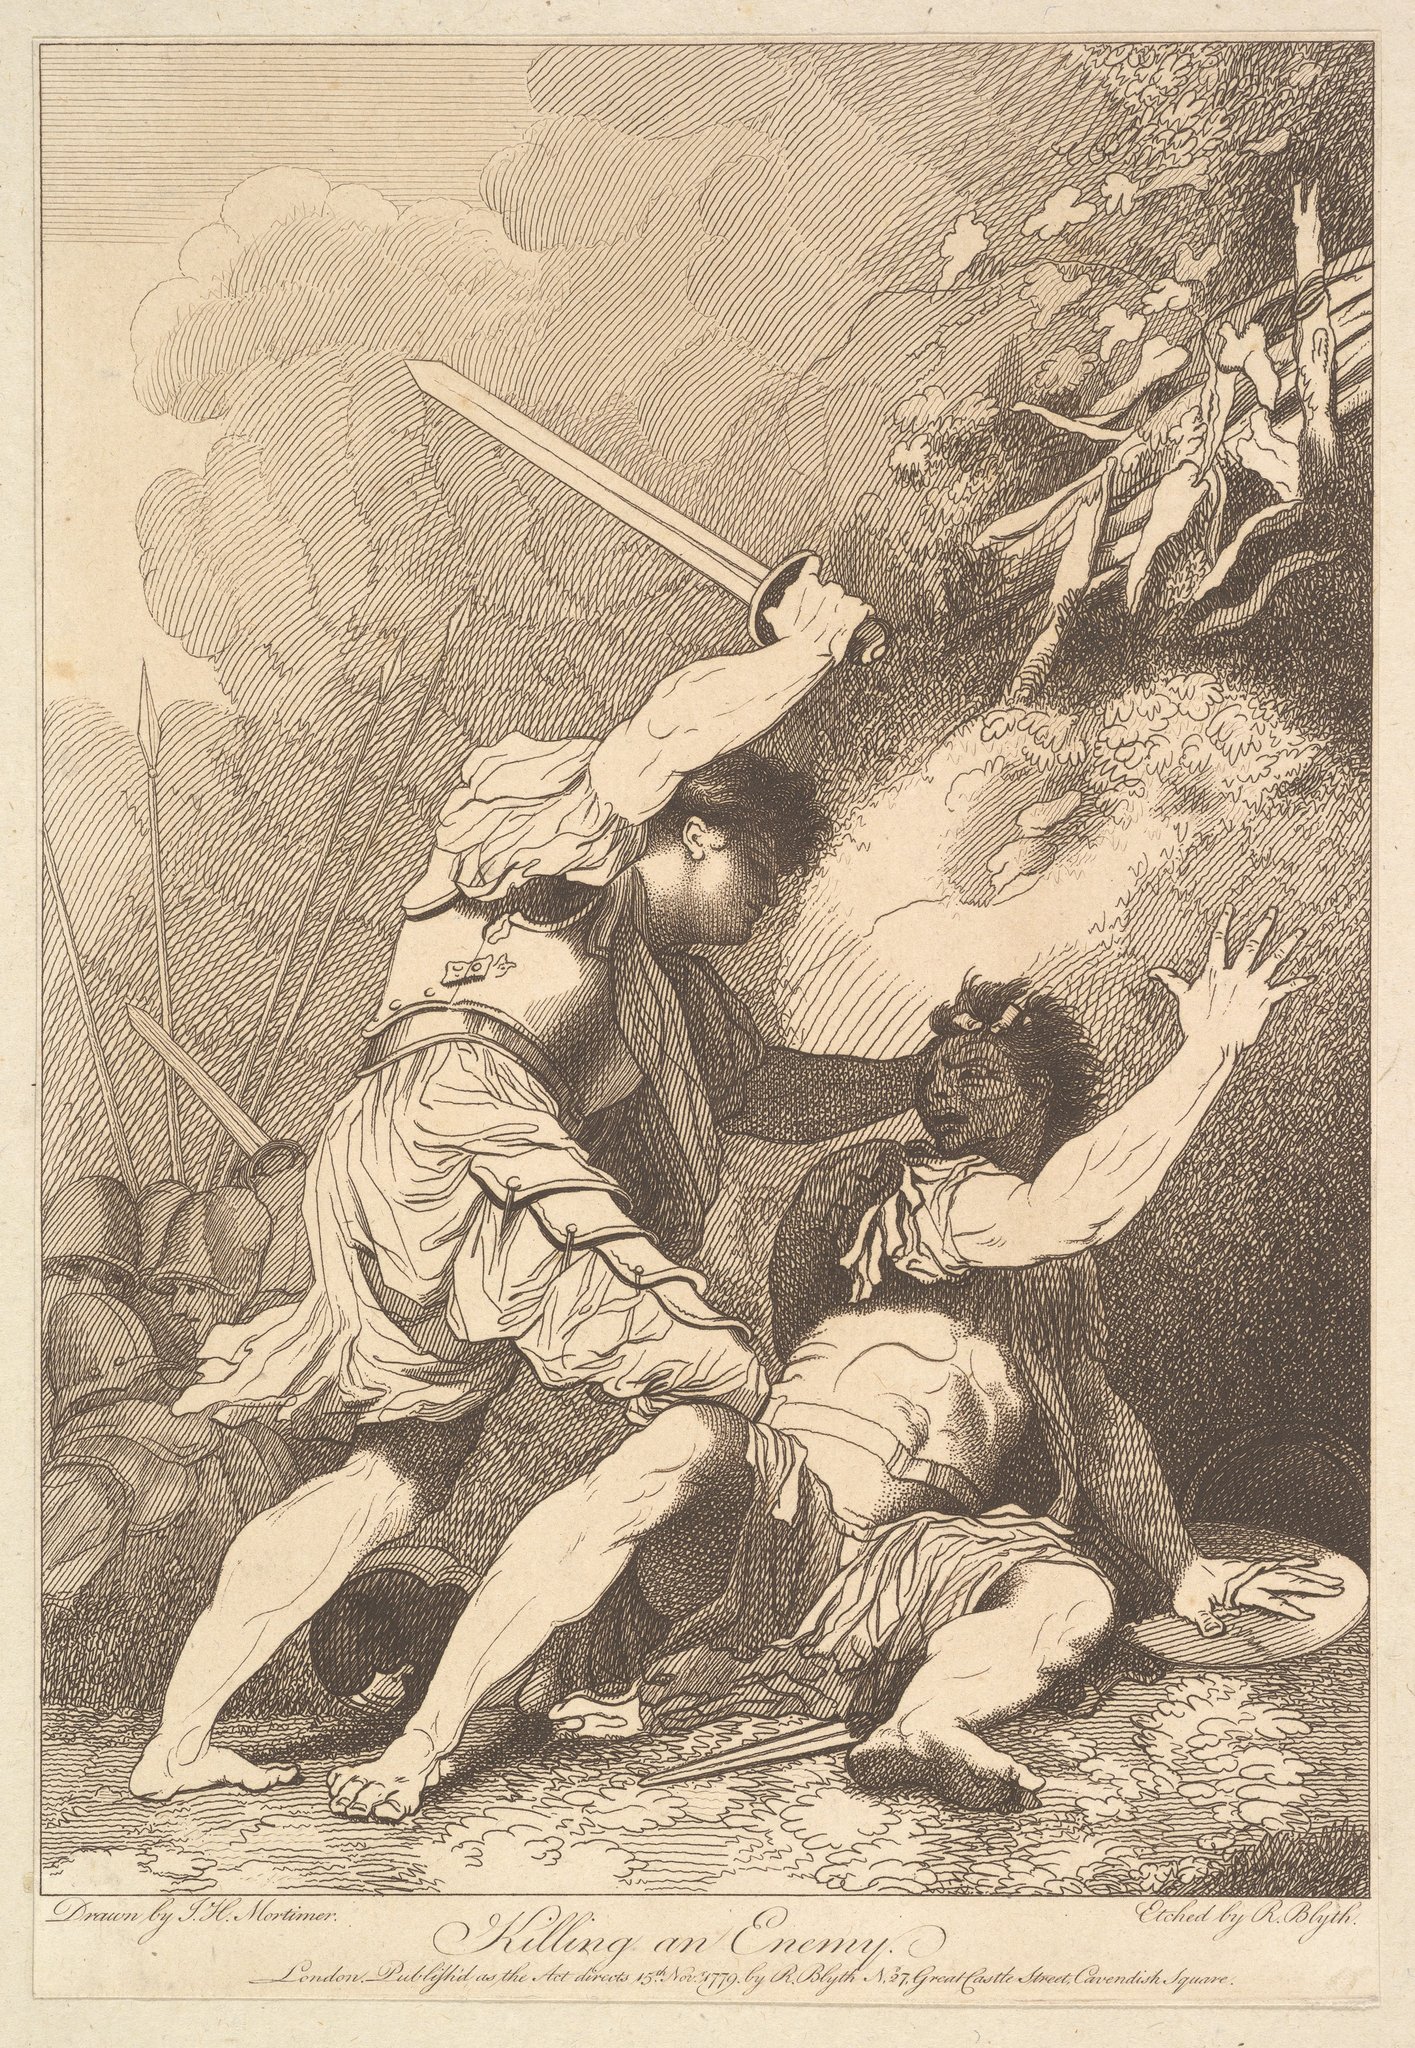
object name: print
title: Killing an Enemy, from "Banditti Variously Employed"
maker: robert blyth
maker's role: artist and publisher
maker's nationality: british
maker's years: 1750-1784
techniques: etching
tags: swords,fear,men